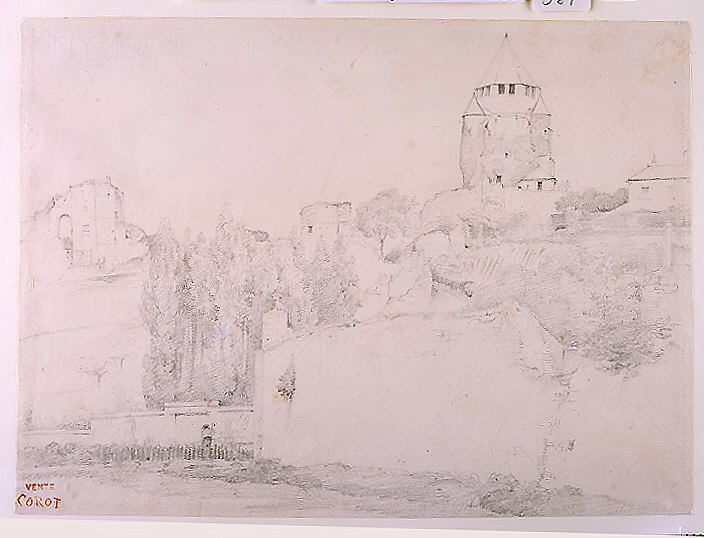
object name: drawing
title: View of Provins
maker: jean-baptiste-camille corot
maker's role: artist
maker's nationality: french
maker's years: 1796-1875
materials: graphite, paper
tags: buildings,villages